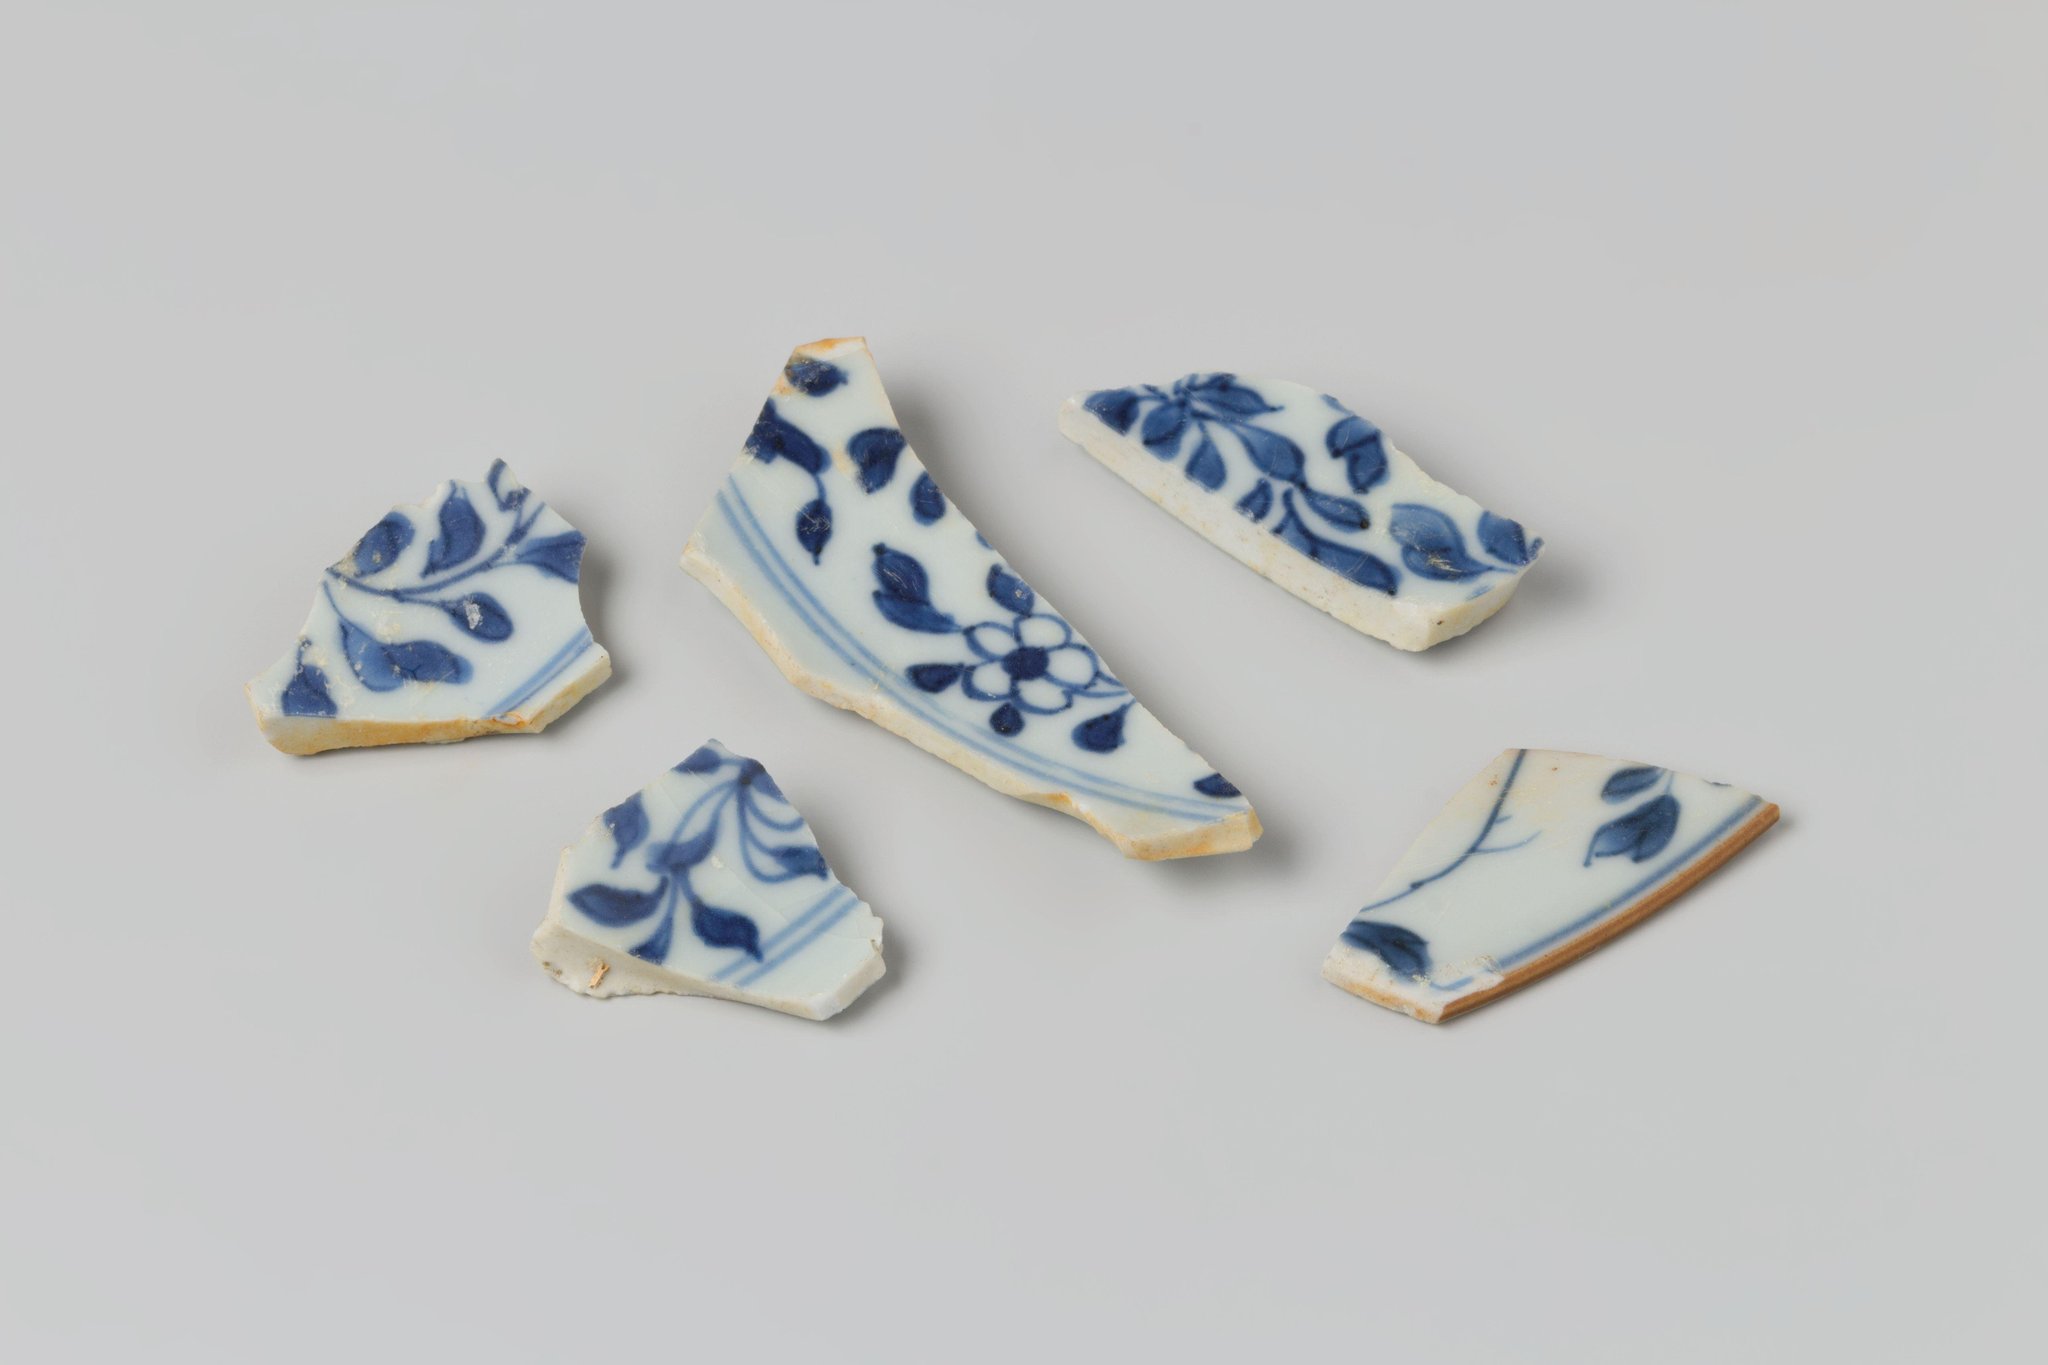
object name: plate dish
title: Scherven van borden uit het wrak van de Oost-Indiëvaarder Hollandia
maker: Anonymous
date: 1700-1743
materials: porcelain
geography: netherlands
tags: verenigde oostindische compagnie, hollandia (schip), annet